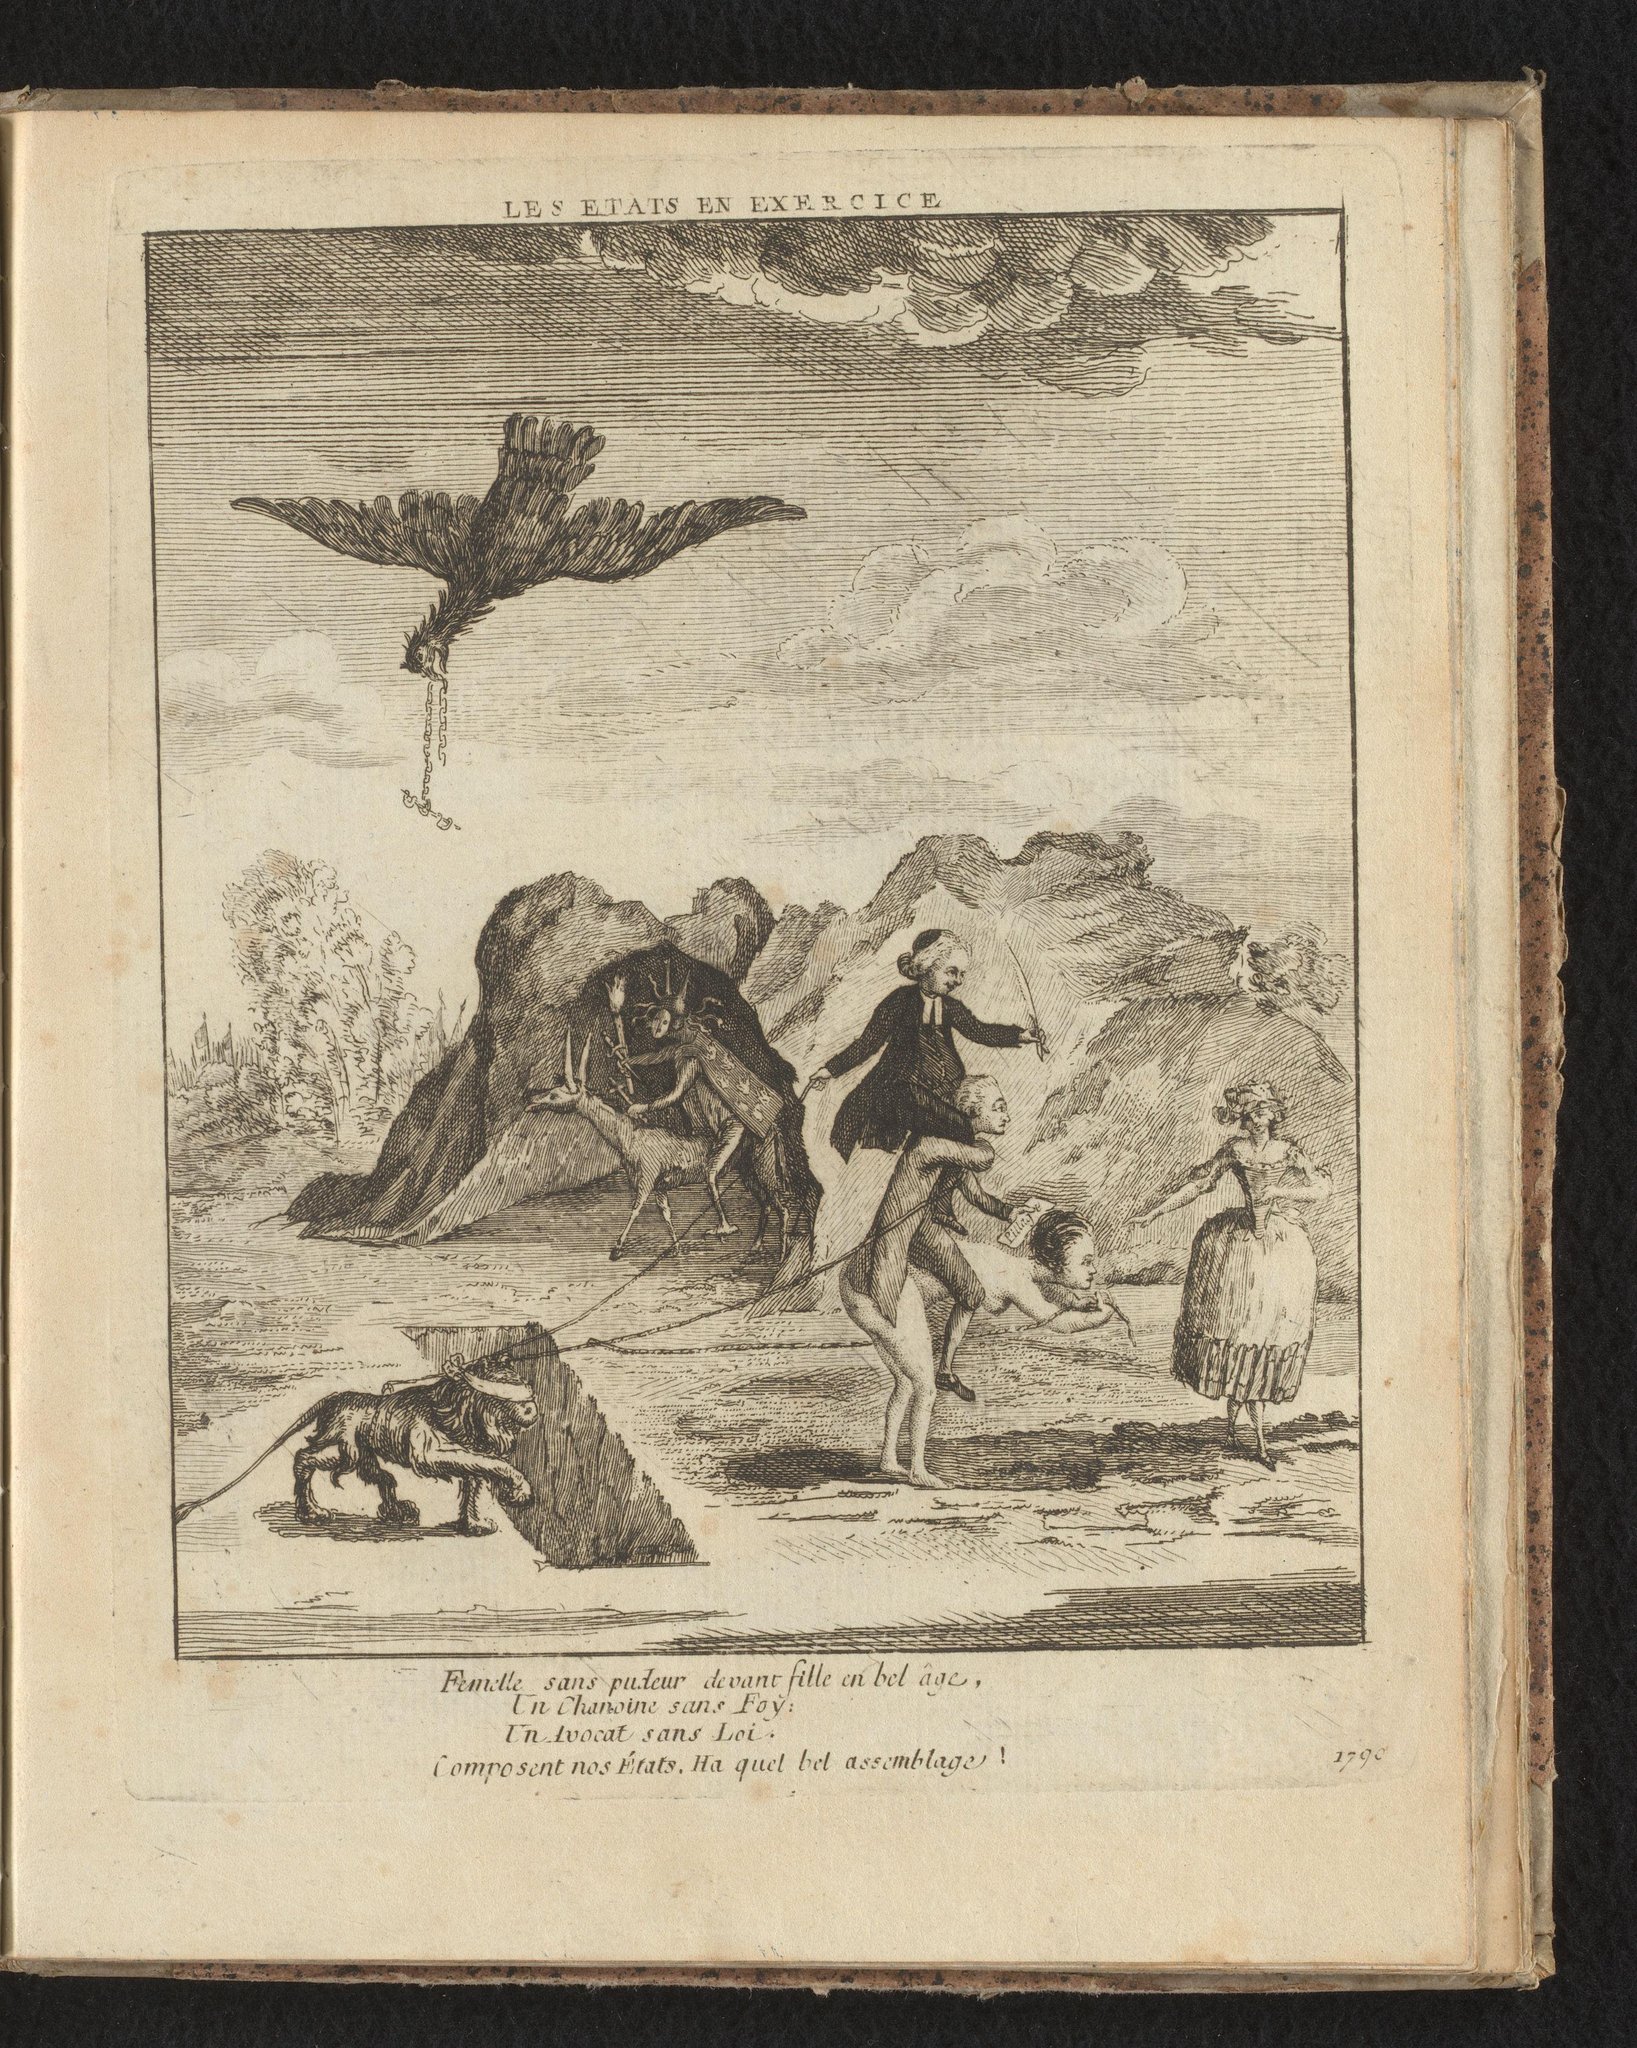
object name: print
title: Spotprent op Hendrik van der Noot en Petrus van Eupen, 1790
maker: Anonymous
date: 1787-1790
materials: paper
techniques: engraving, etching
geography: southern netherlands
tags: brussels, politician, brabant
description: Spotprent waarin Hendrik van der Noot en Petrus van Eupen zitten op de rug van een naakte vrouw. Zij zijn met kettingen verbonden aan de geblinddoekte Brabantse leeuw en worden door een jonge vrouw (Madame Pinau?) gelokt waardoor de blinde leeuw in een kuil dreigt te stappen. In de lucht de Oostenrijkse adelaar (met de boeien in de bek). Op de achtergrond een duivel op een ezel in een grot. Met vierreglig Frans onderschrift. Hierbij de datum 1790. Onderdeel van de gebundelde verzameling prenten betrekking hebbend op de gebeurtenissen van de Brabantse Omwenteling en de periode 1787-1790.